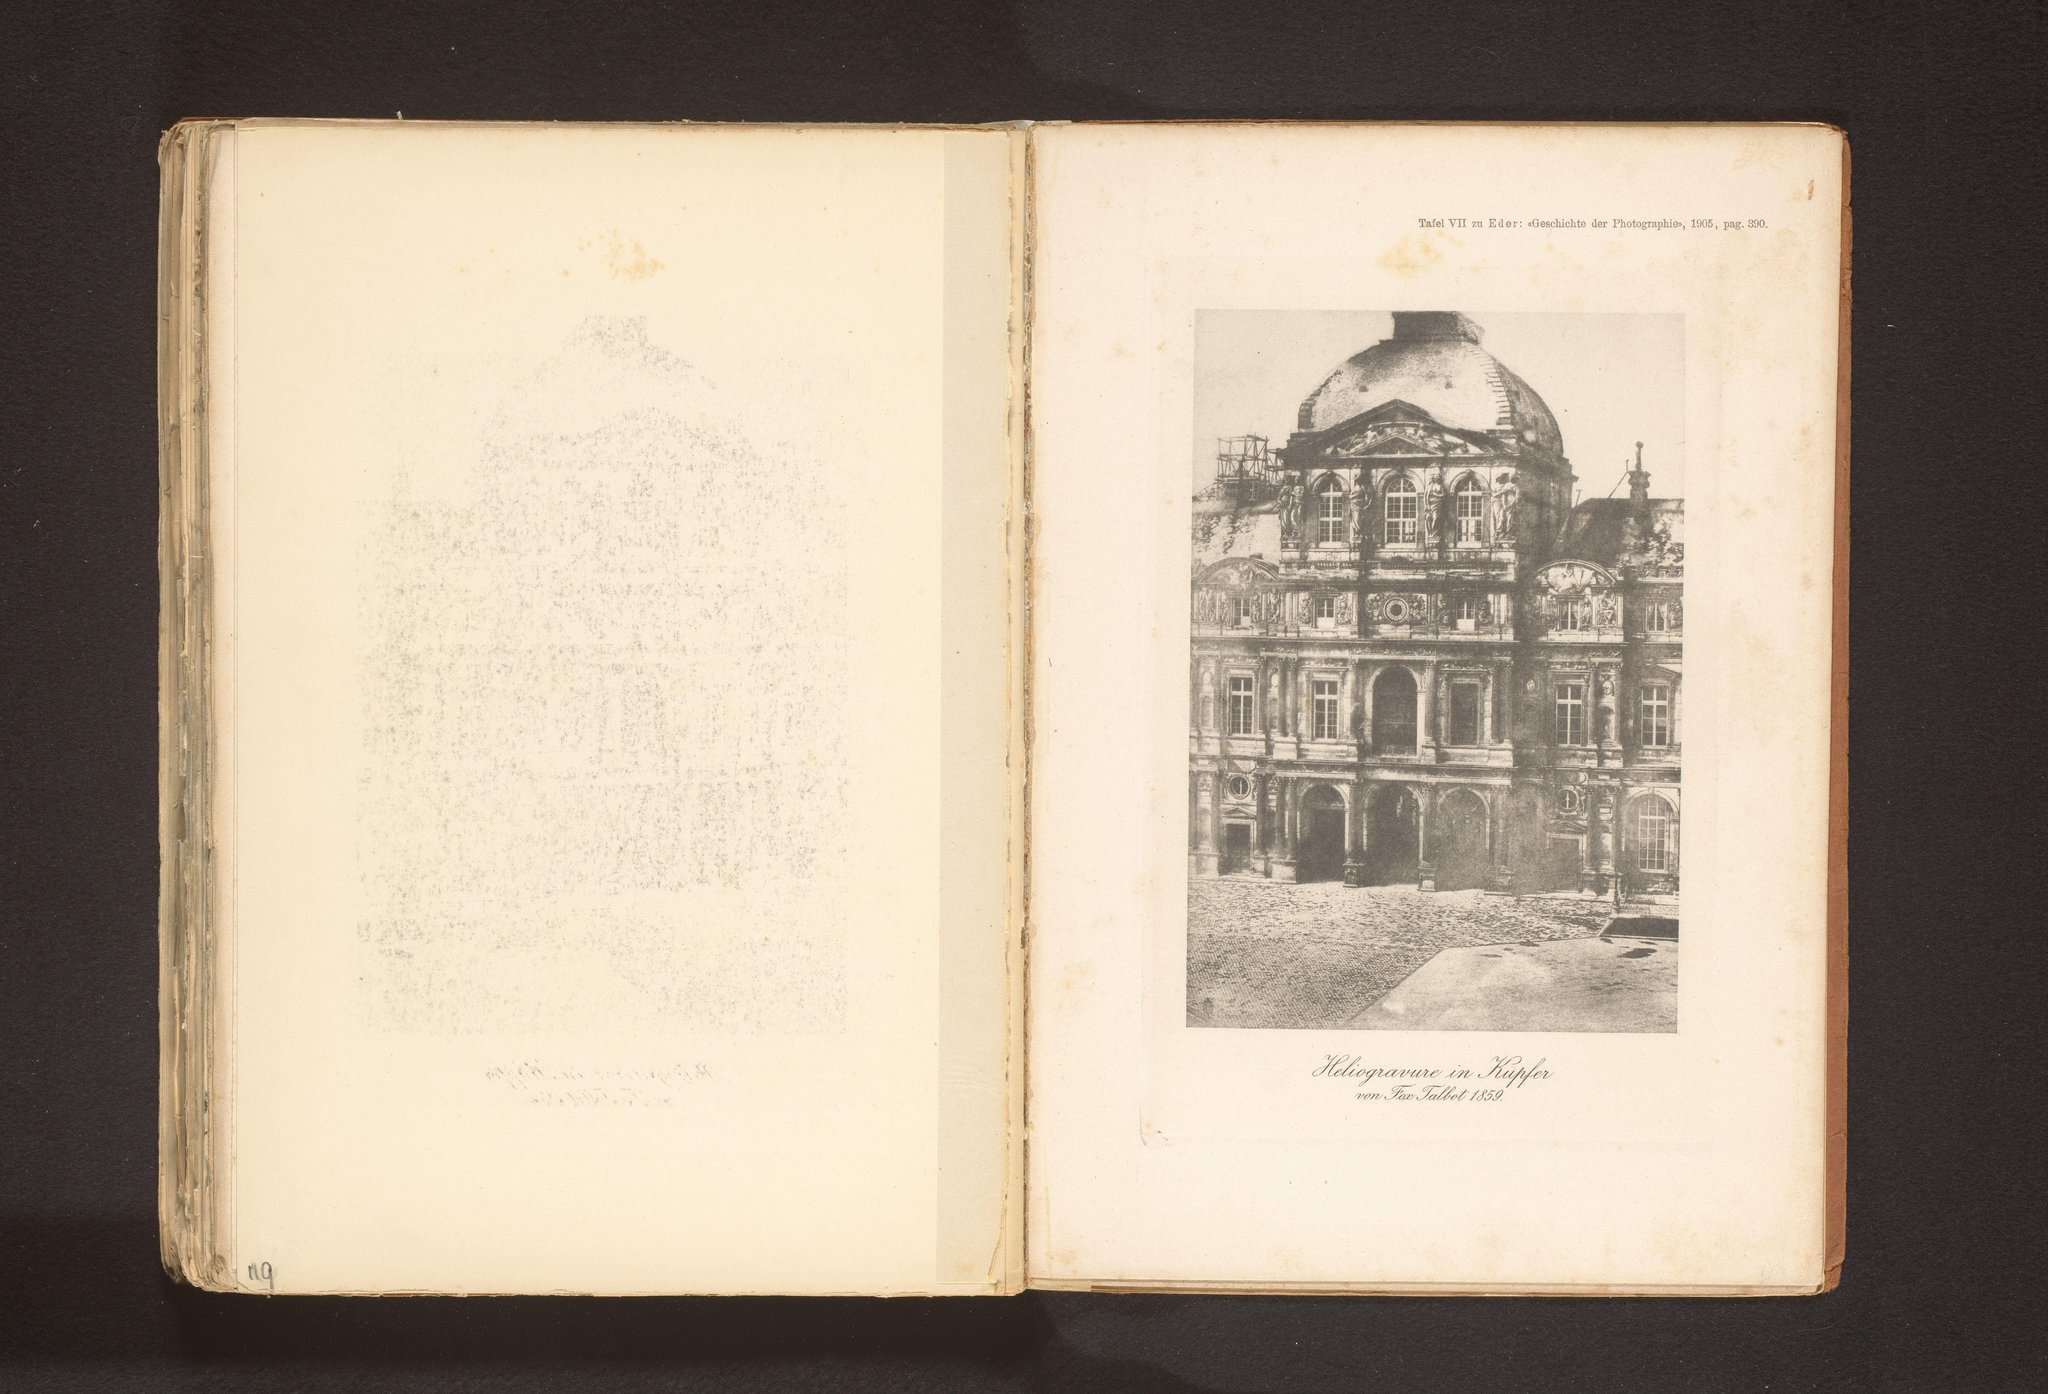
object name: photomechanical print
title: Deel van de gevel van het Musée du Louvre te Parijs, gezien vanaf het Place du Carrousel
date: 1900-1905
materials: paper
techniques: photoaquatint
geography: place du carrousel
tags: permanent exhibition, museum, façade (of house or building)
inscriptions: number: ‘Tafel VII’